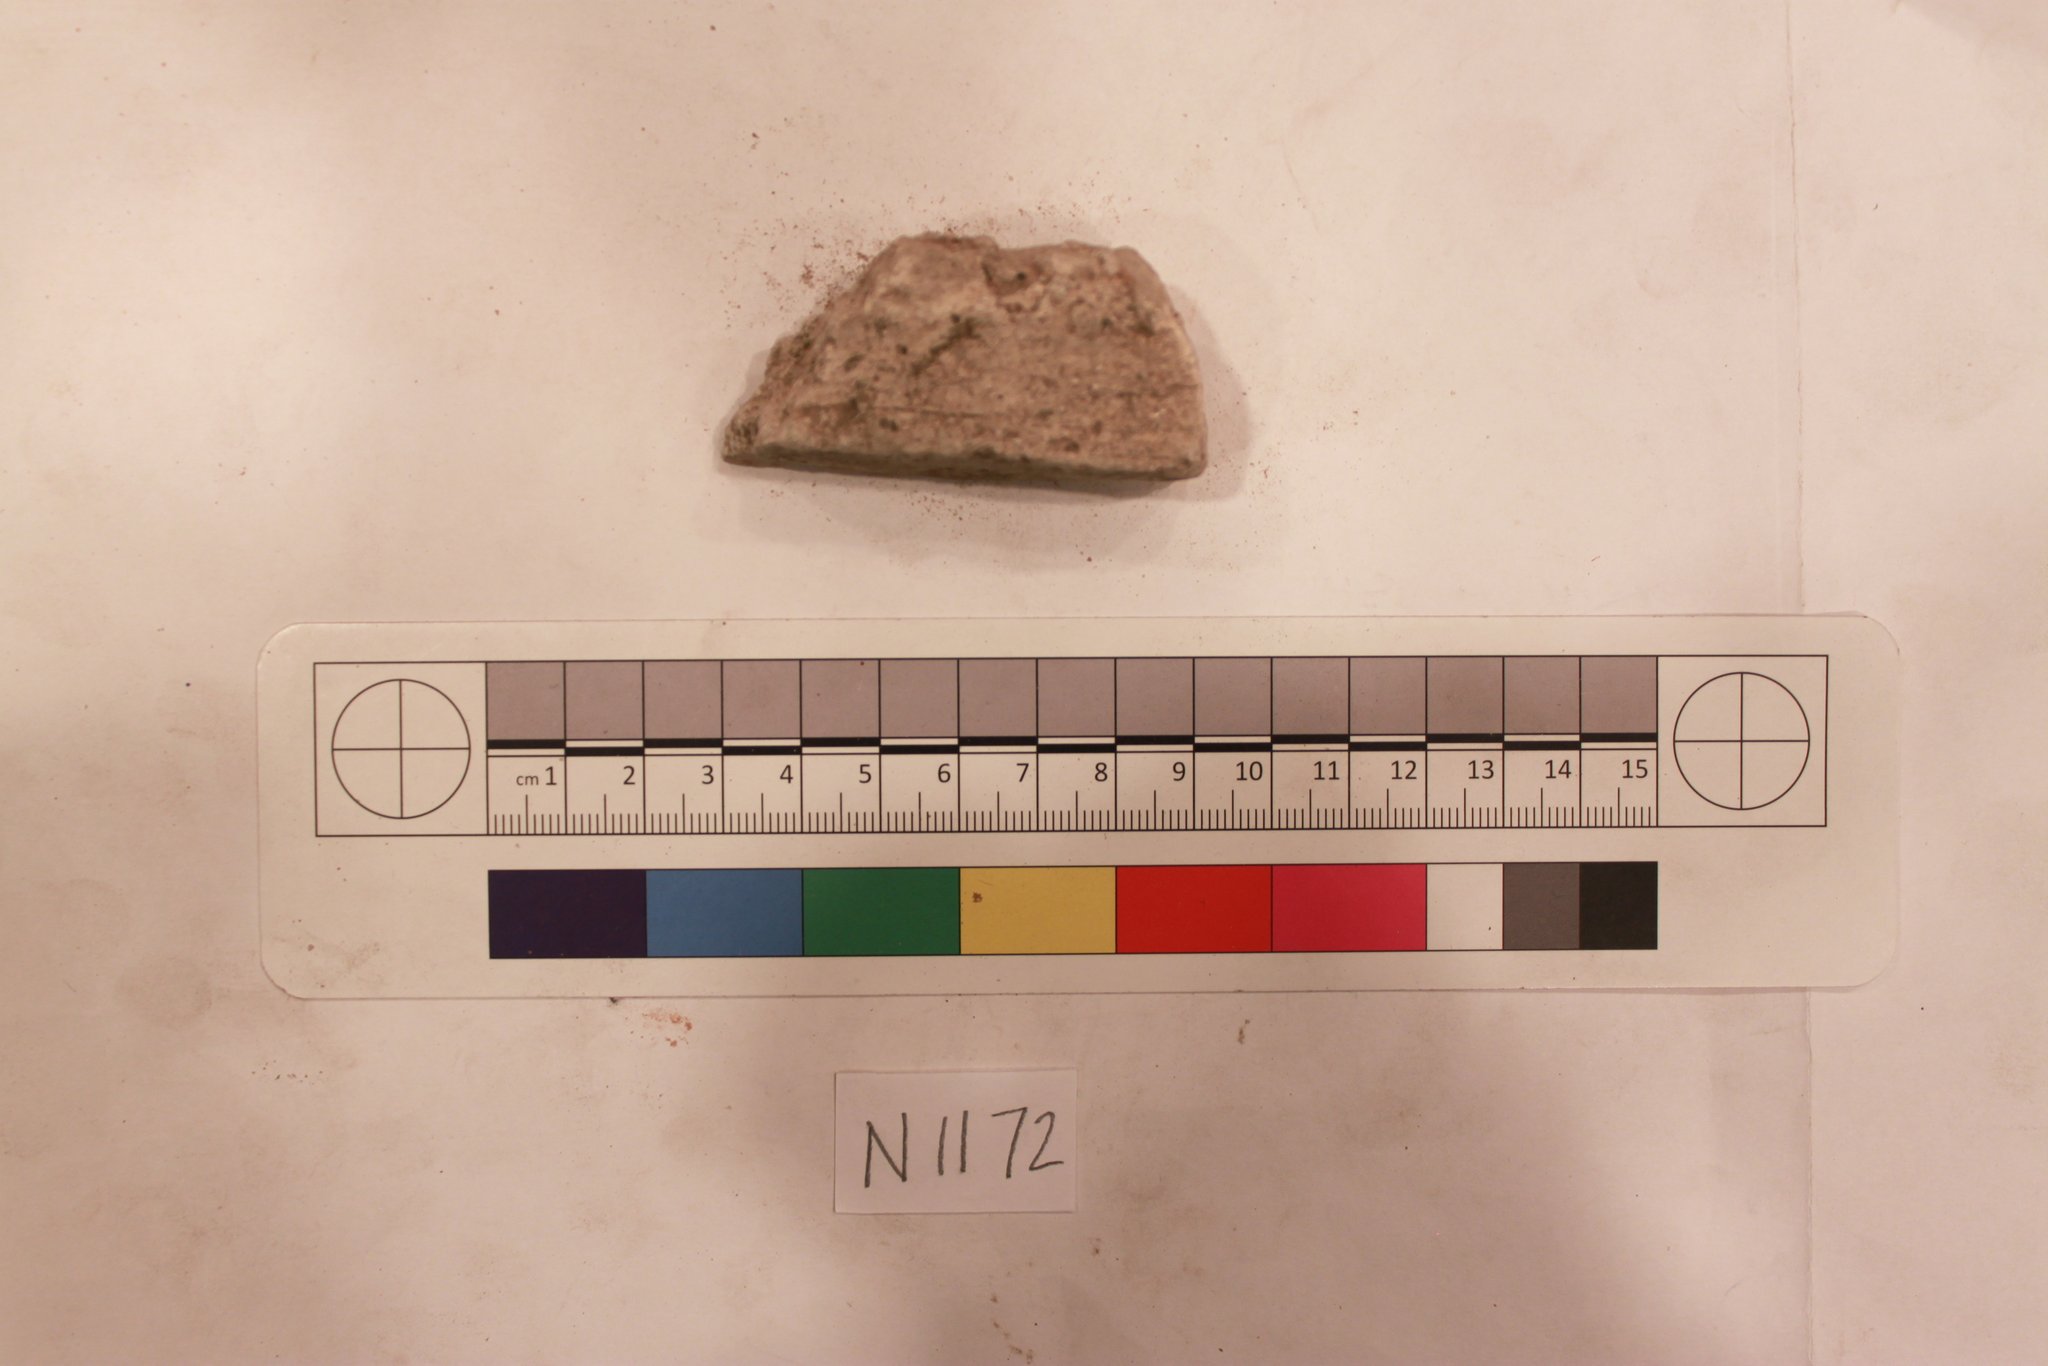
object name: fragment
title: Stucco Fragment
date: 701-1200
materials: plaster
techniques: carving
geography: iran